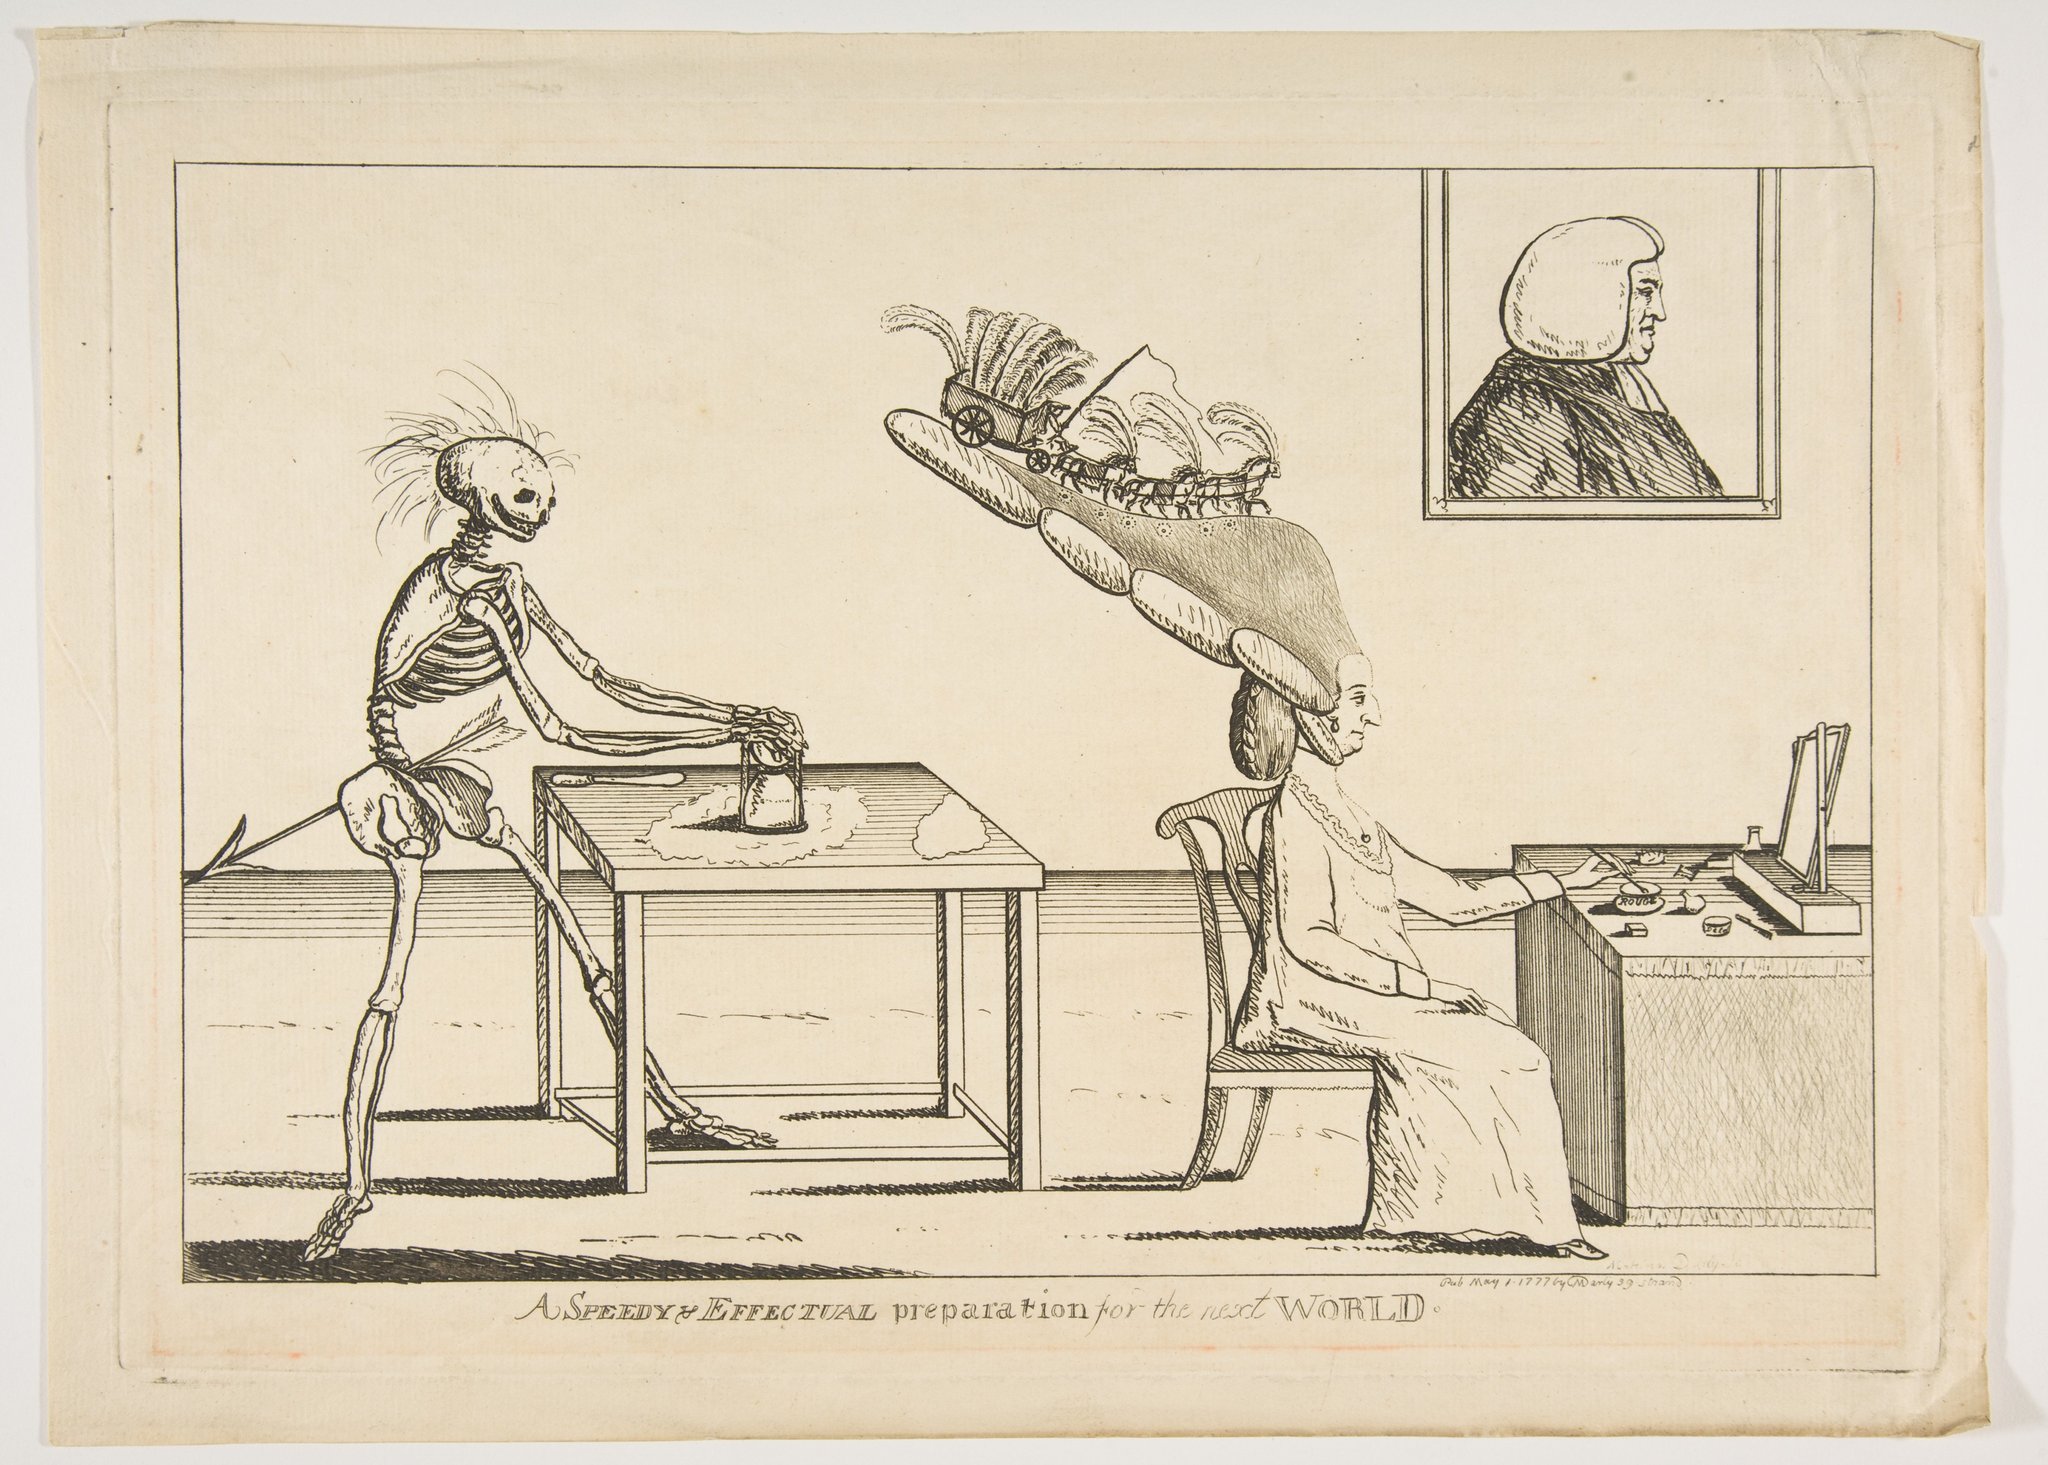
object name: print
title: A Speedy & Effectual Preparation for the Next World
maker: matthias darly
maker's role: artist and publisher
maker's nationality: british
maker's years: 1720-1780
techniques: etching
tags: skeletons,hair,men,women,caricature,wigs